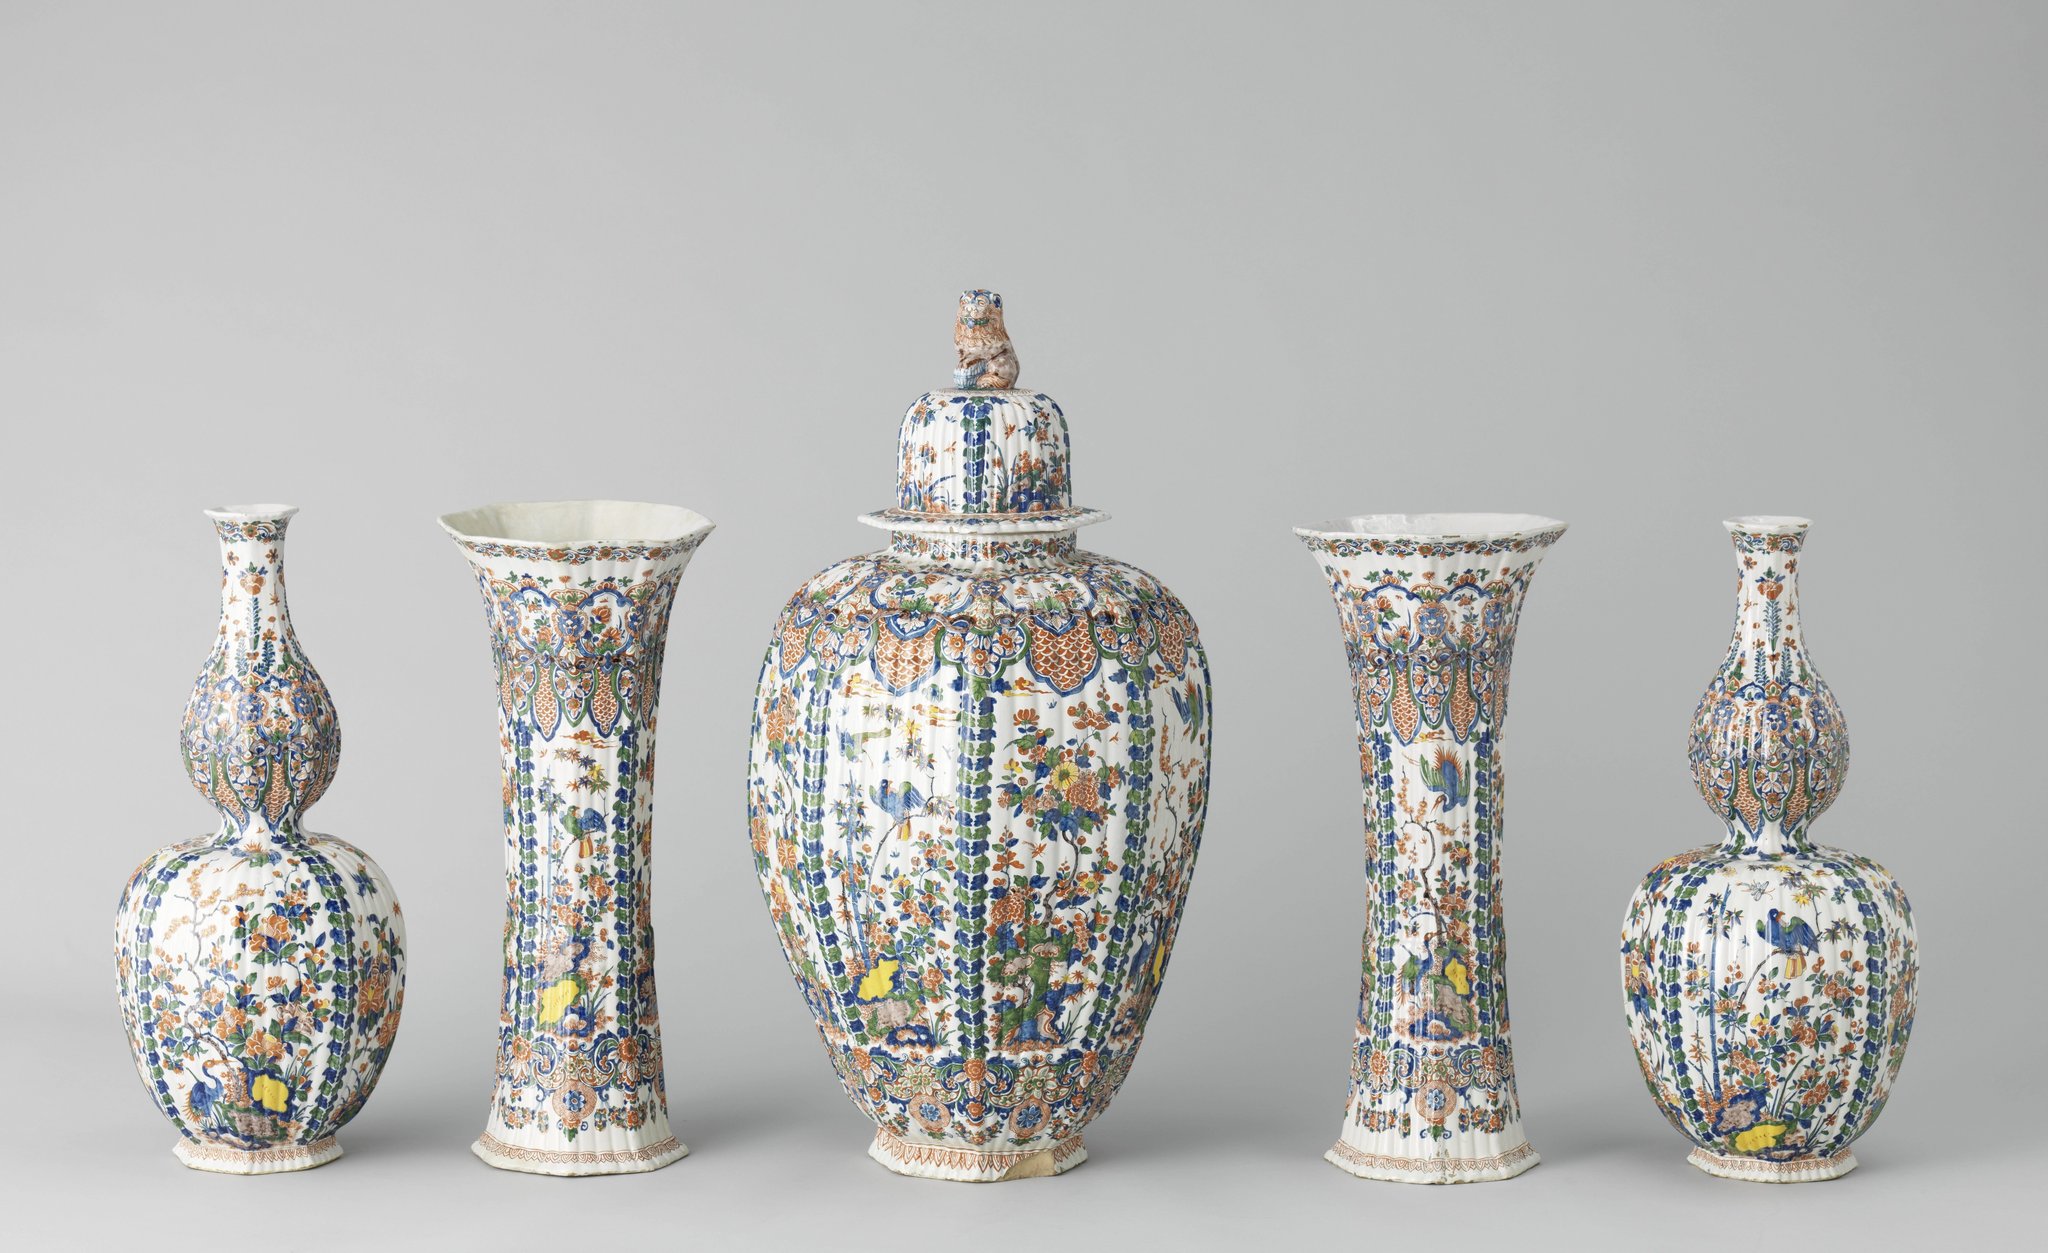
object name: kaststel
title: Garniture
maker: Anonymous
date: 1695-1715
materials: earthenware, glaze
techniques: painted, polychromy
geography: delft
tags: flowers ~ ornament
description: These five vases, in both form and decoration, clearly belong together. They were specially made as a set for display on a cupboard or a table. The ribbed form of the vases is typically European, while the painted decoration is inspired by Chinese and Japanese porcelain.